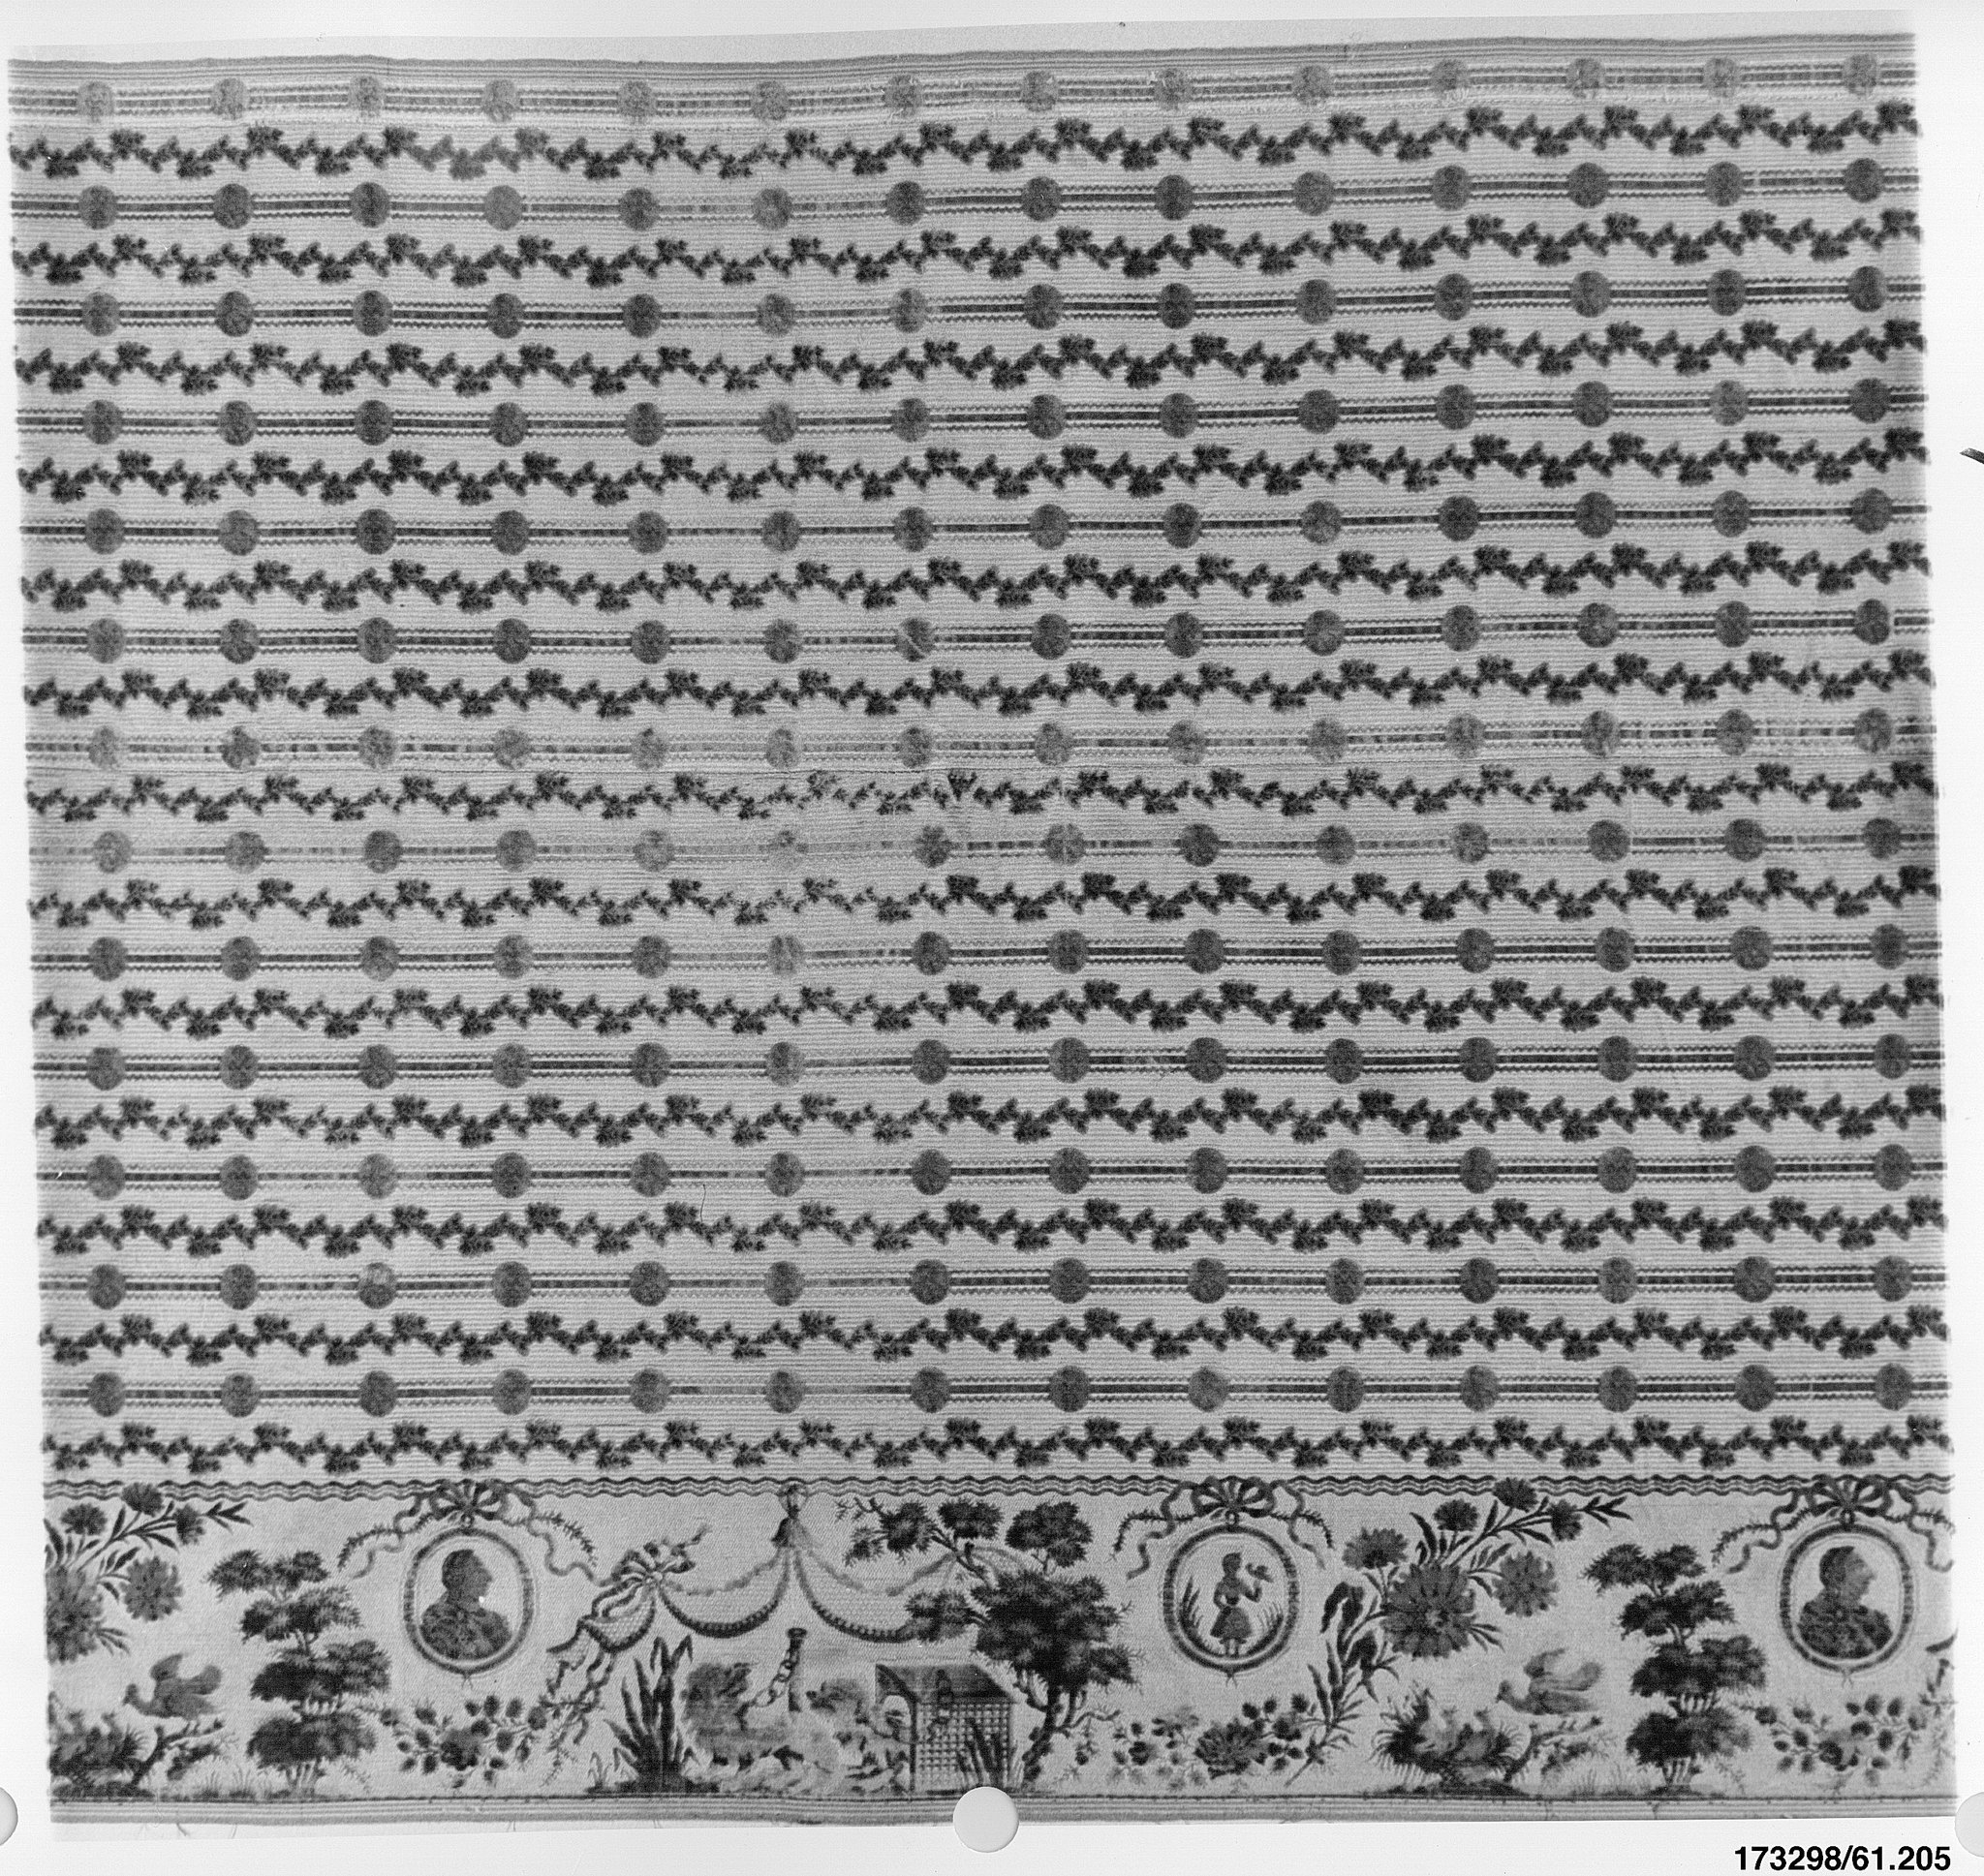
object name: piece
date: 1759-1788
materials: silk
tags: human figures,birds,profiles,flowers